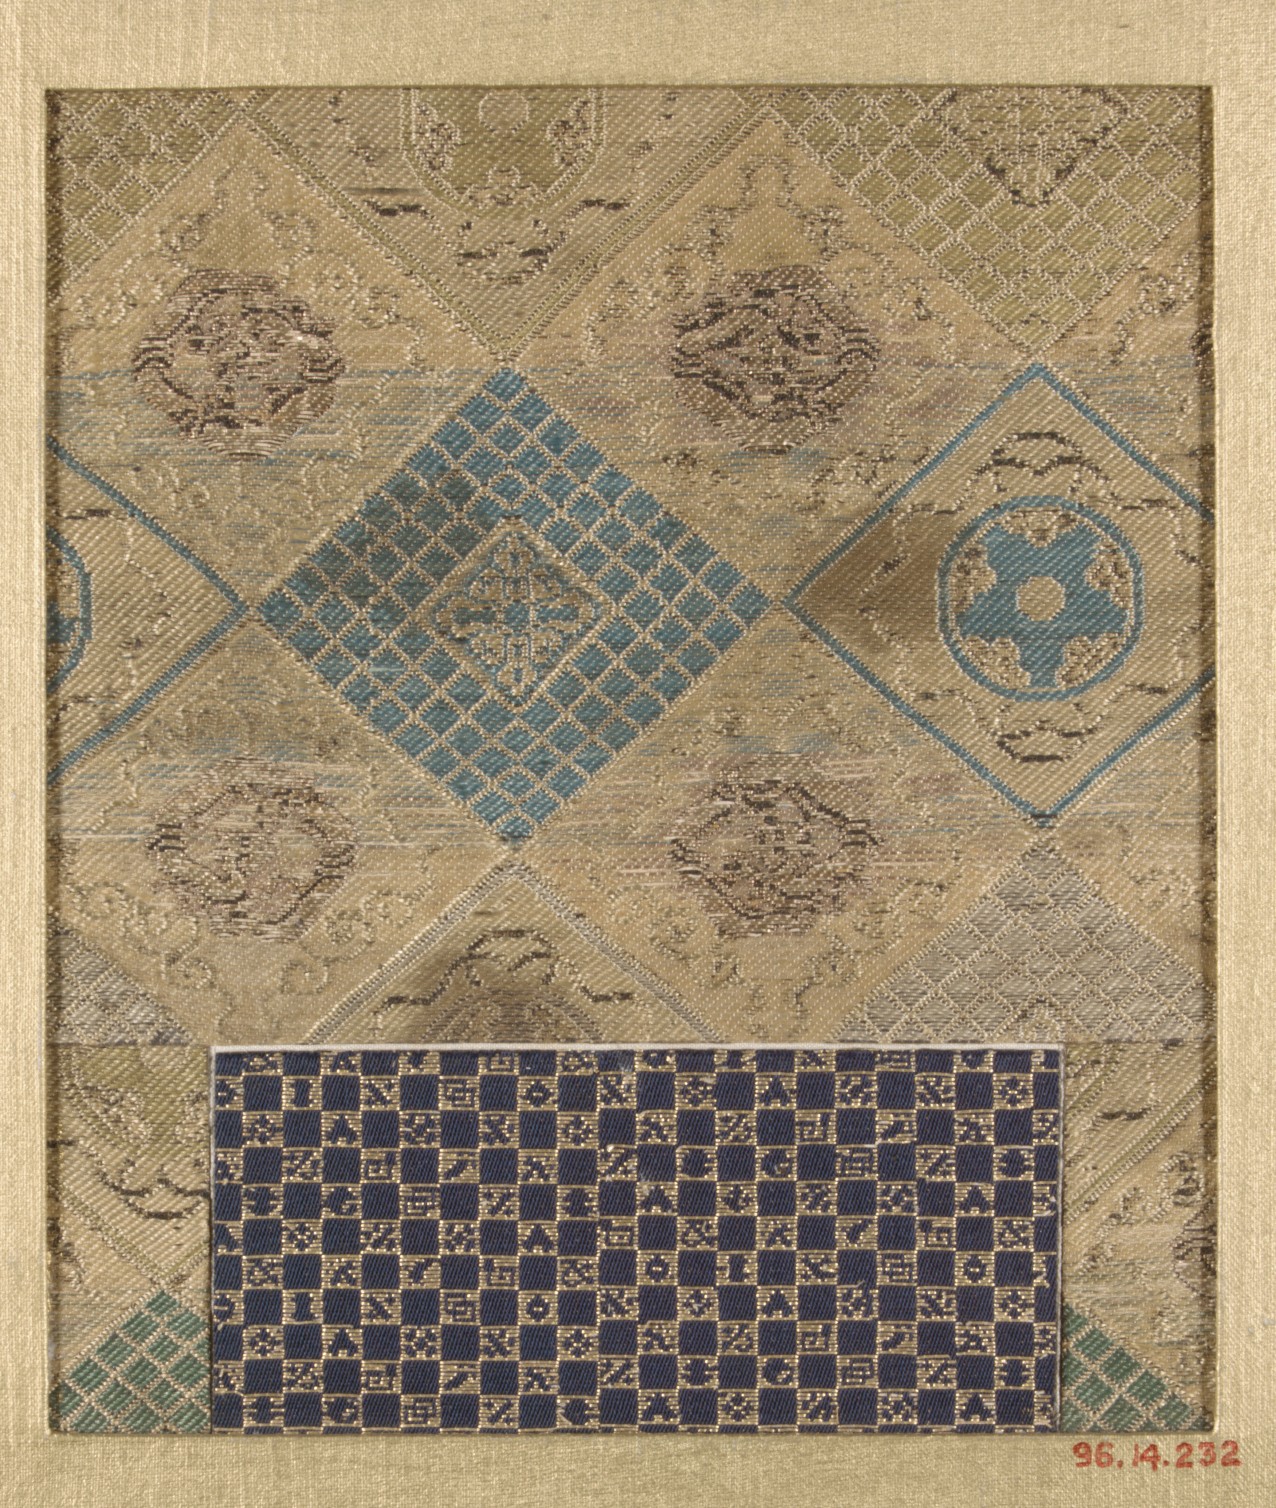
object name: piece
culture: japanese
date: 1701-1900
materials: silk